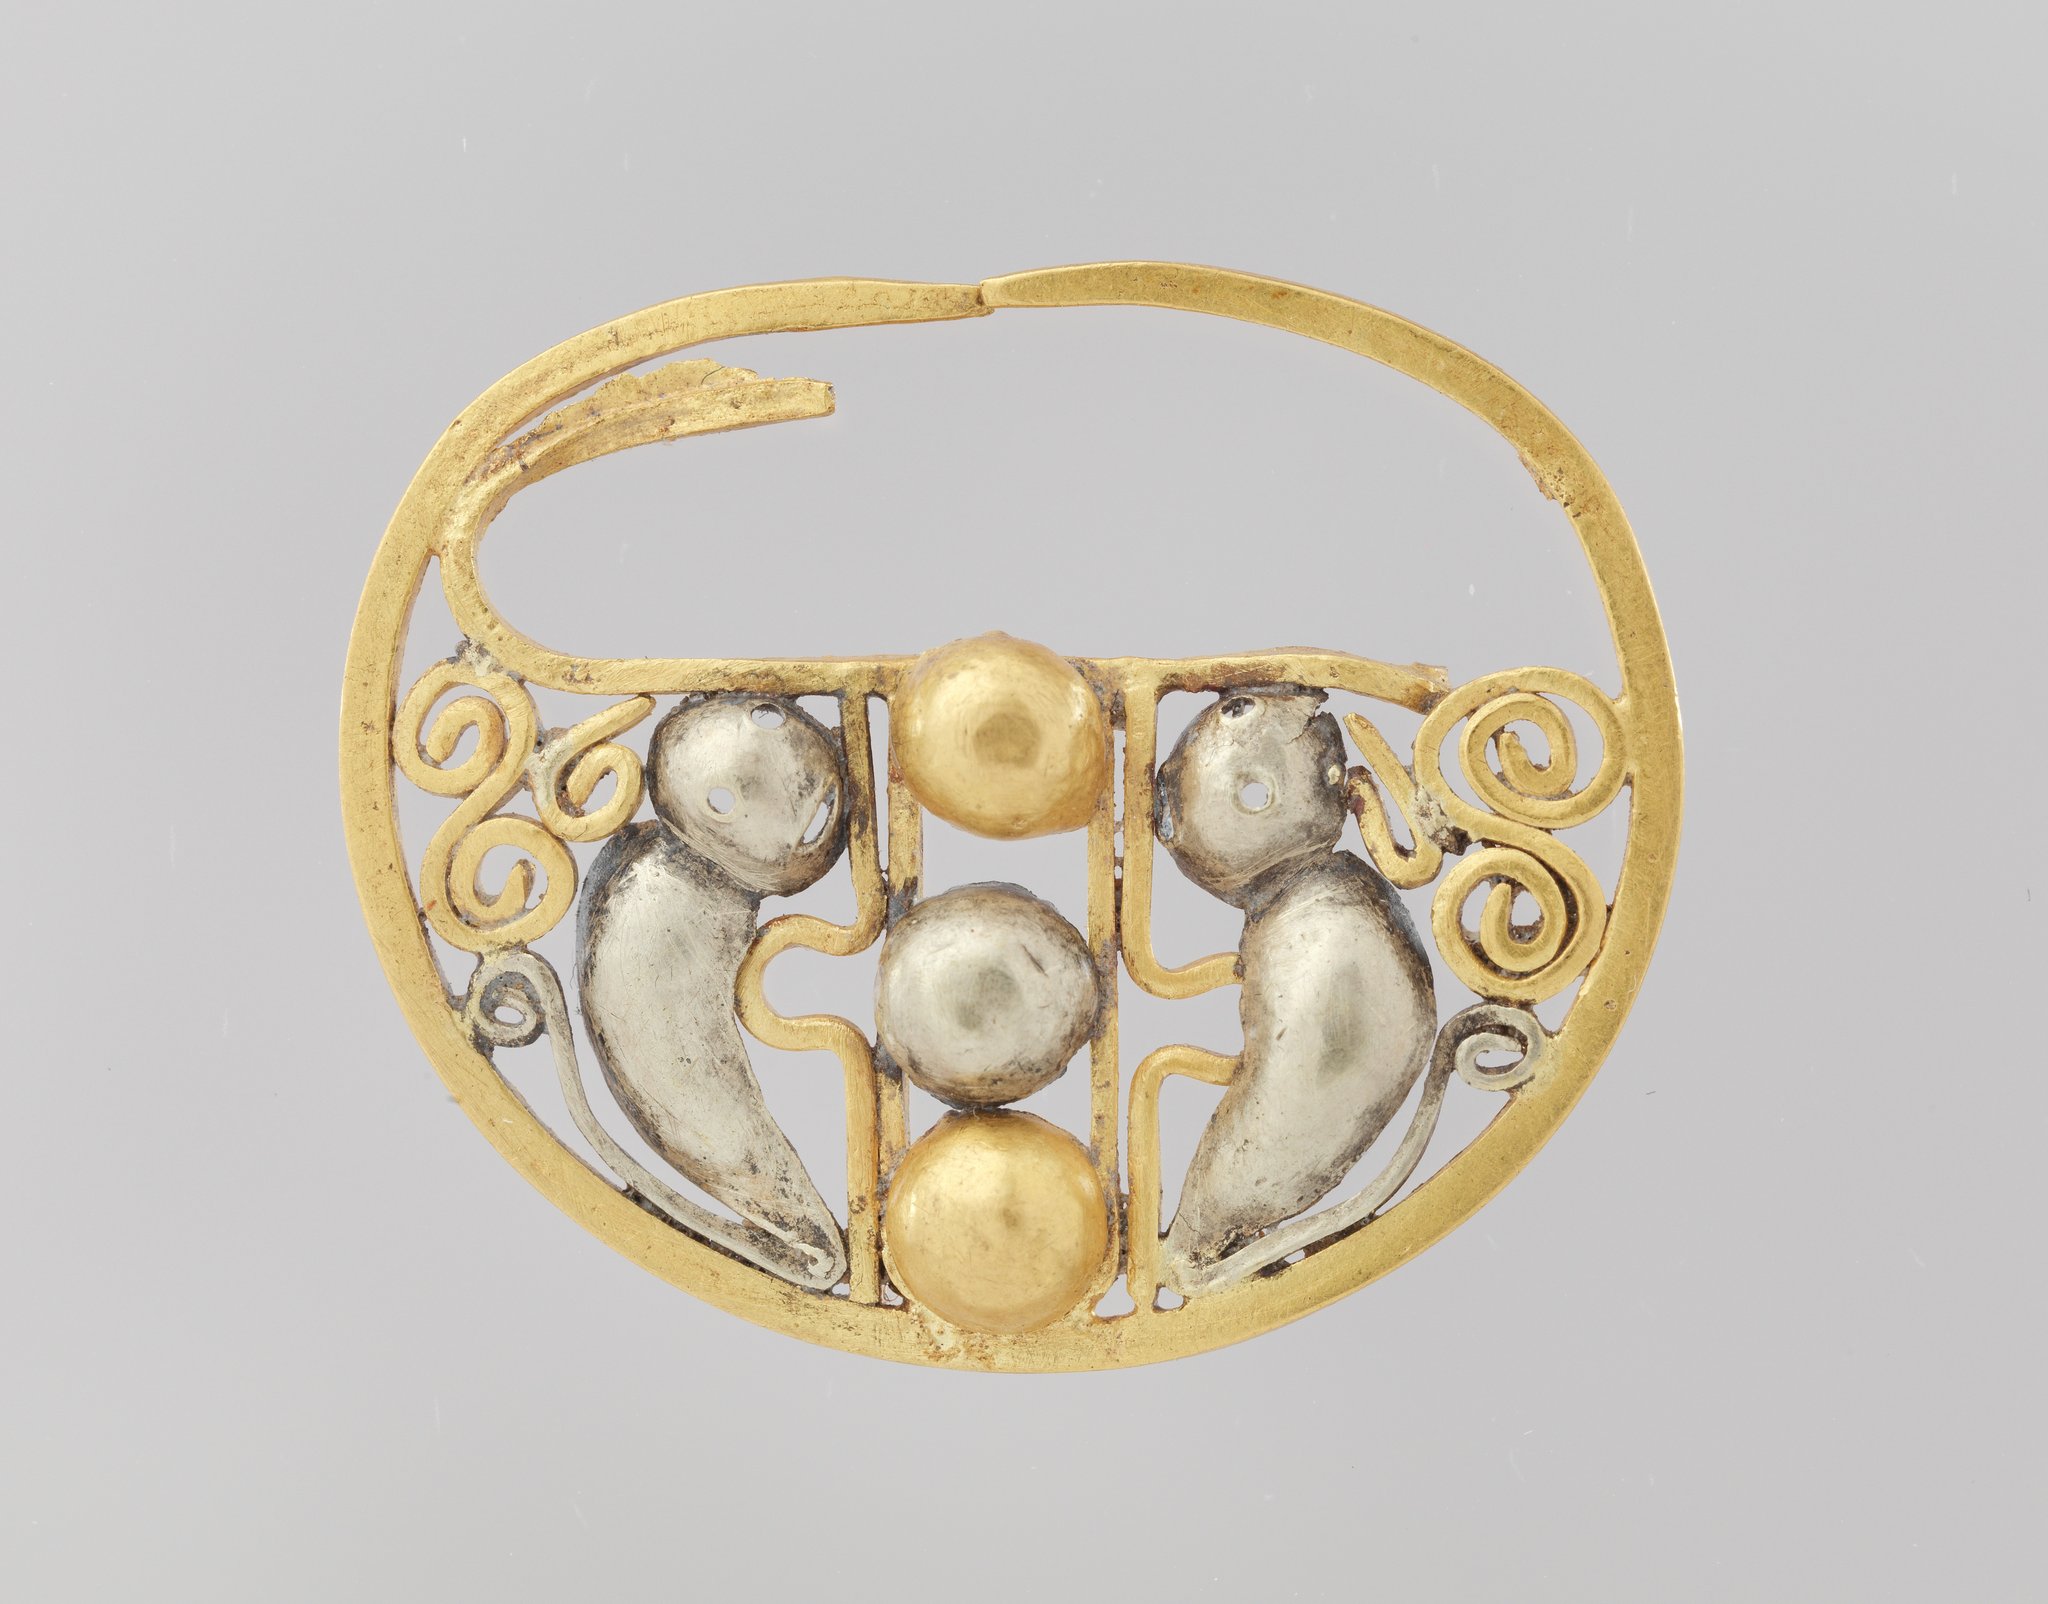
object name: nose ornament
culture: salinar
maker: salinar artist(s)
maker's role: artist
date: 500-100 BCE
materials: gold, silver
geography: peru